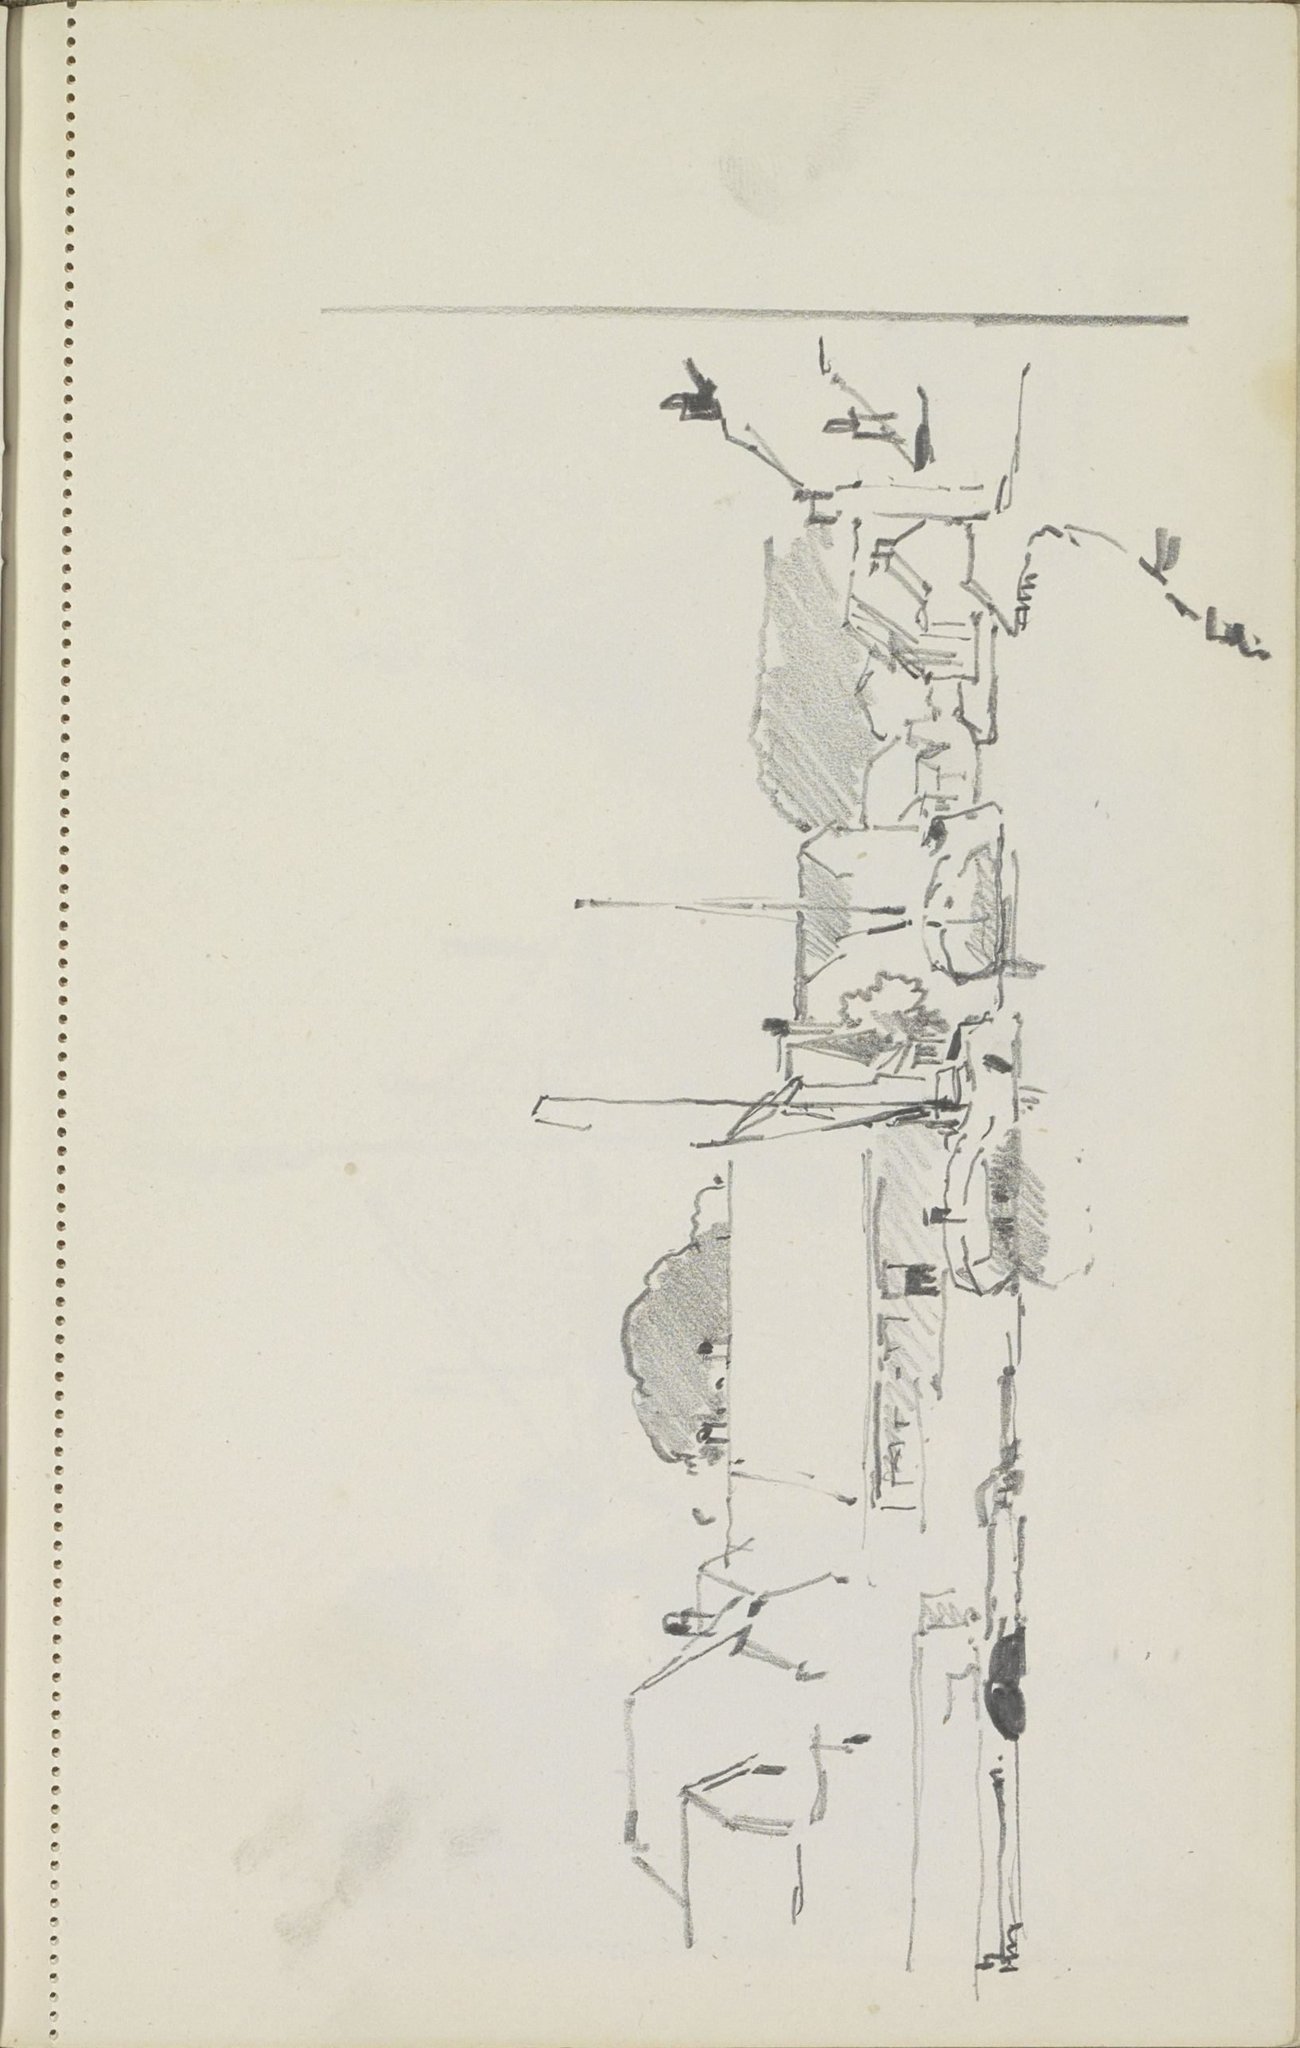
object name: sketchbook leaf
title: Huizen aan een waterkant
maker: cornelis vreedenburgh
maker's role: draughtsman, print maker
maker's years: 1880-1946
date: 1890-1946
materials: paper, pencil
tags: city-view, and landscape with man-made constructions, sailing-ship, sailing-boat, landscapes with waters, waterscapes, seascapes (in the temperate zone)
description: Aan de waterkant liggen ook zeilboten aangemeerd. Blad 45 recto uit een schetsboek met 50 bladen.